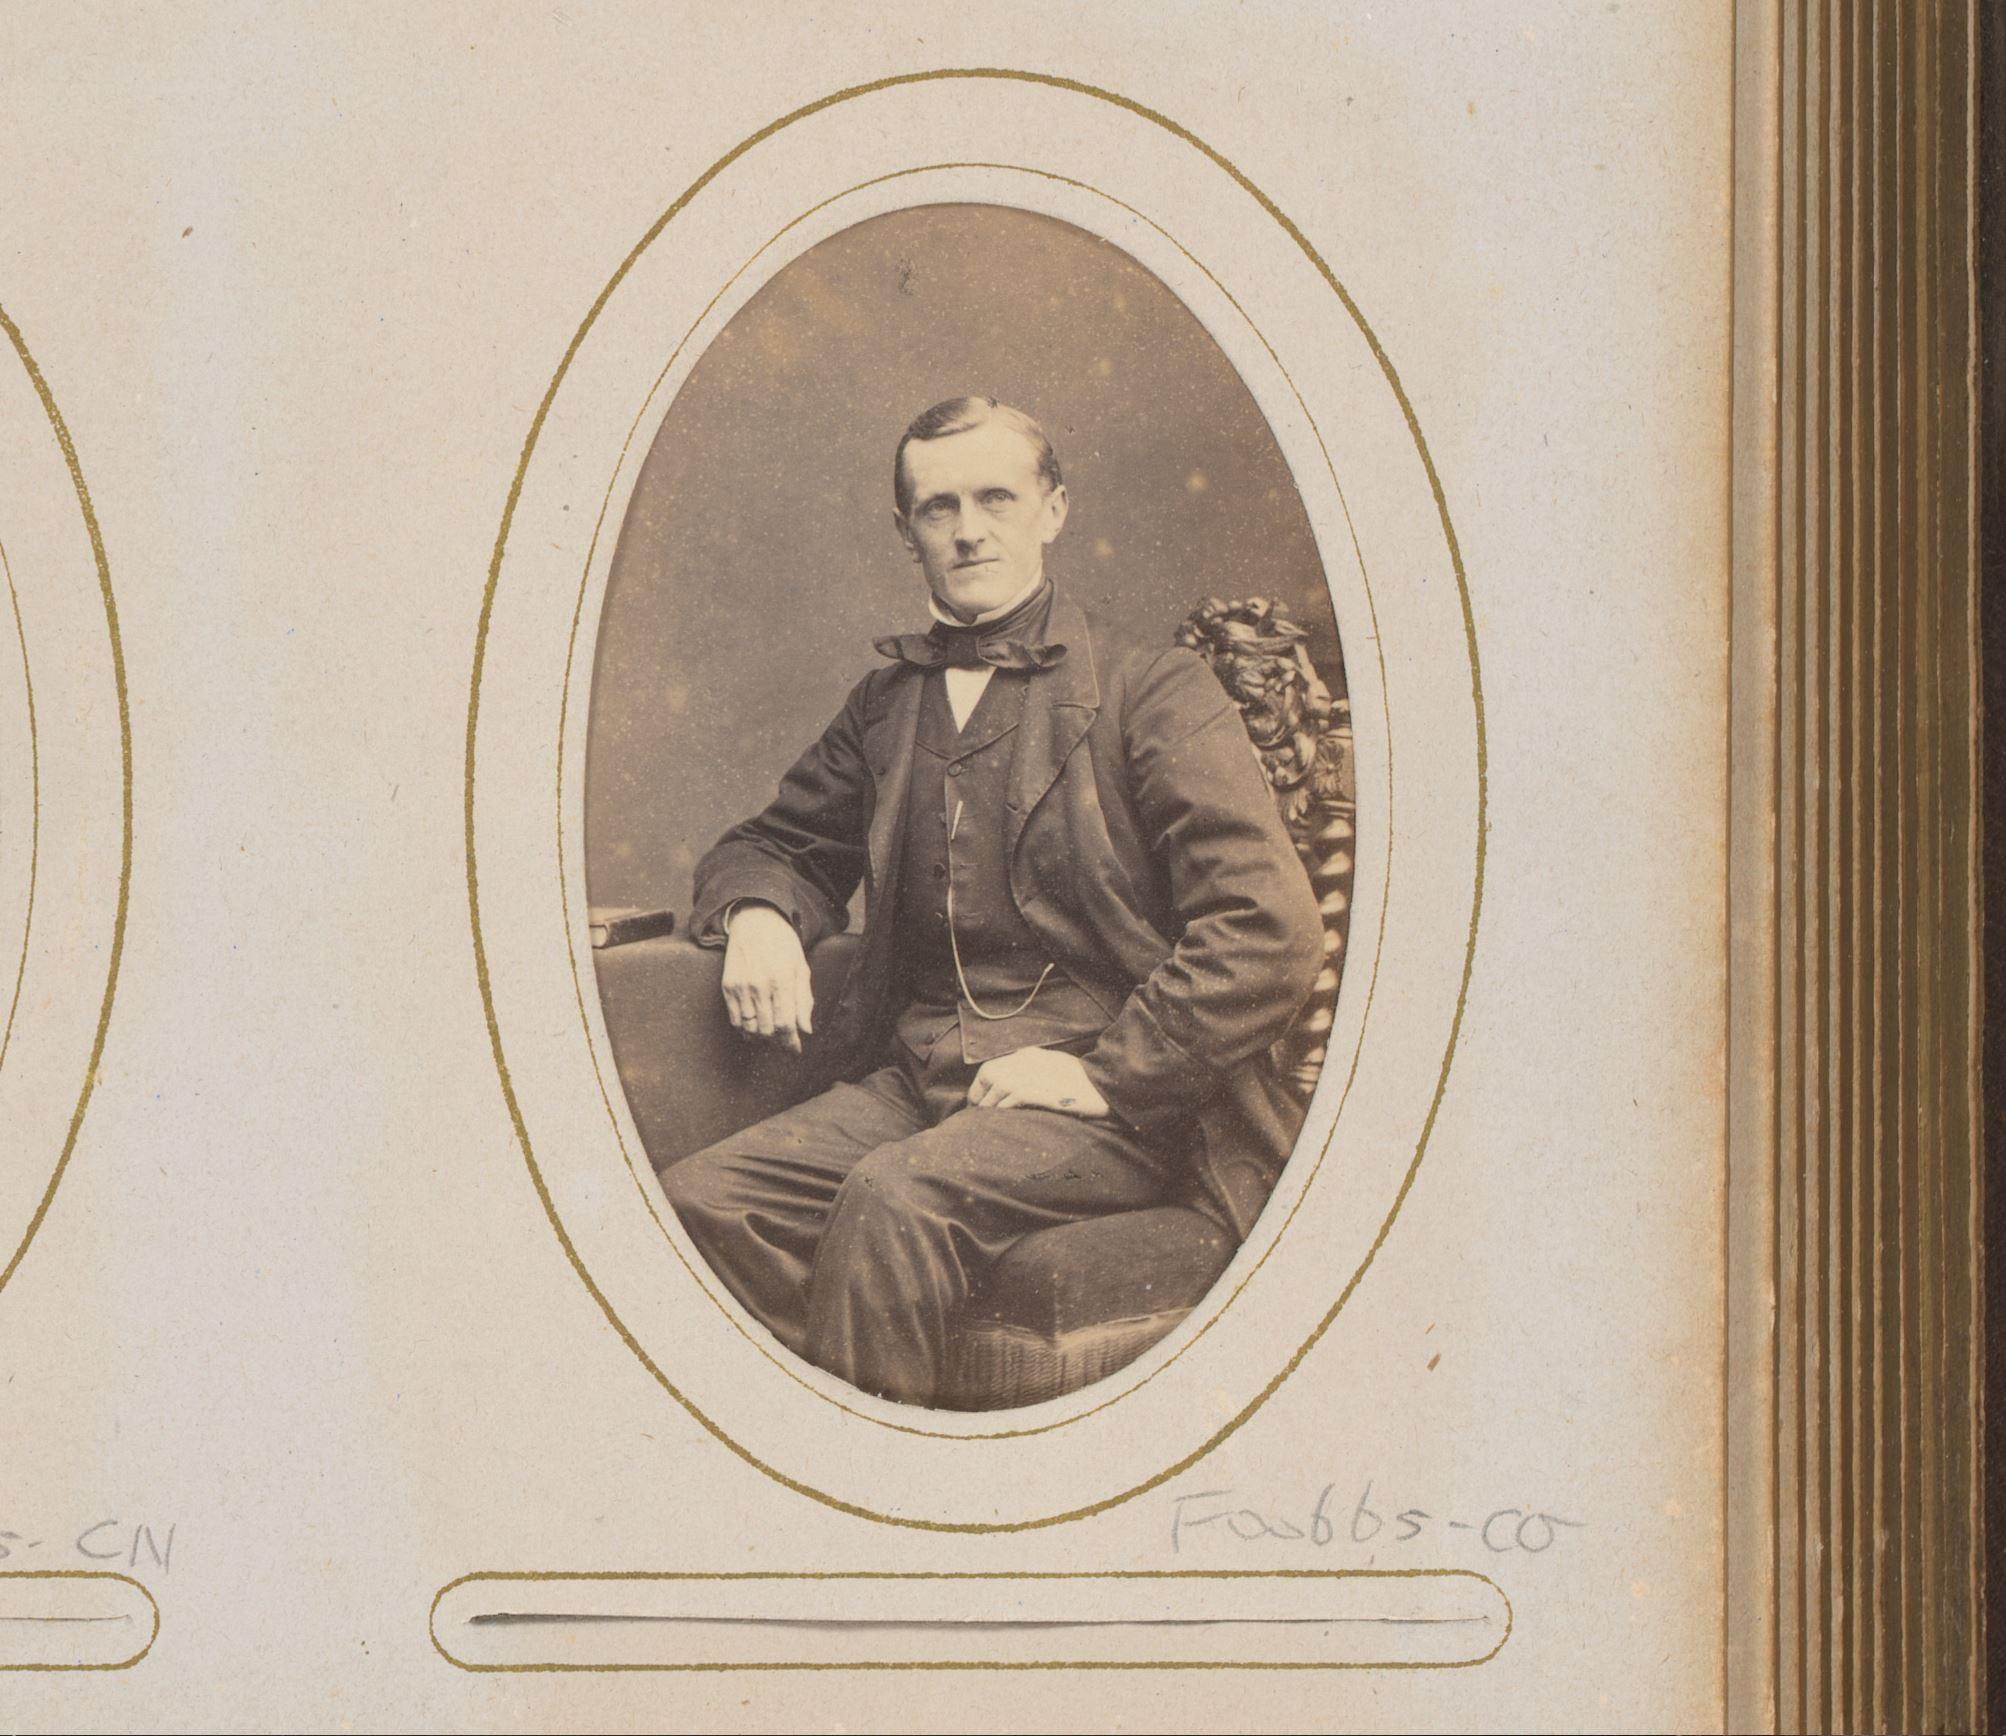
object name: photograph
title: Portret van een man bij een tafel met boek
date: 1857-1864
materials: cardboard, photographic support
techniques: albumen print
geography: amsterdam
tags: historical persons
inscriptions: inscription: ‘Photogr Atelier/ Wegner & Mottu/ Prinsengracht BB, 439/ Amsterdam’